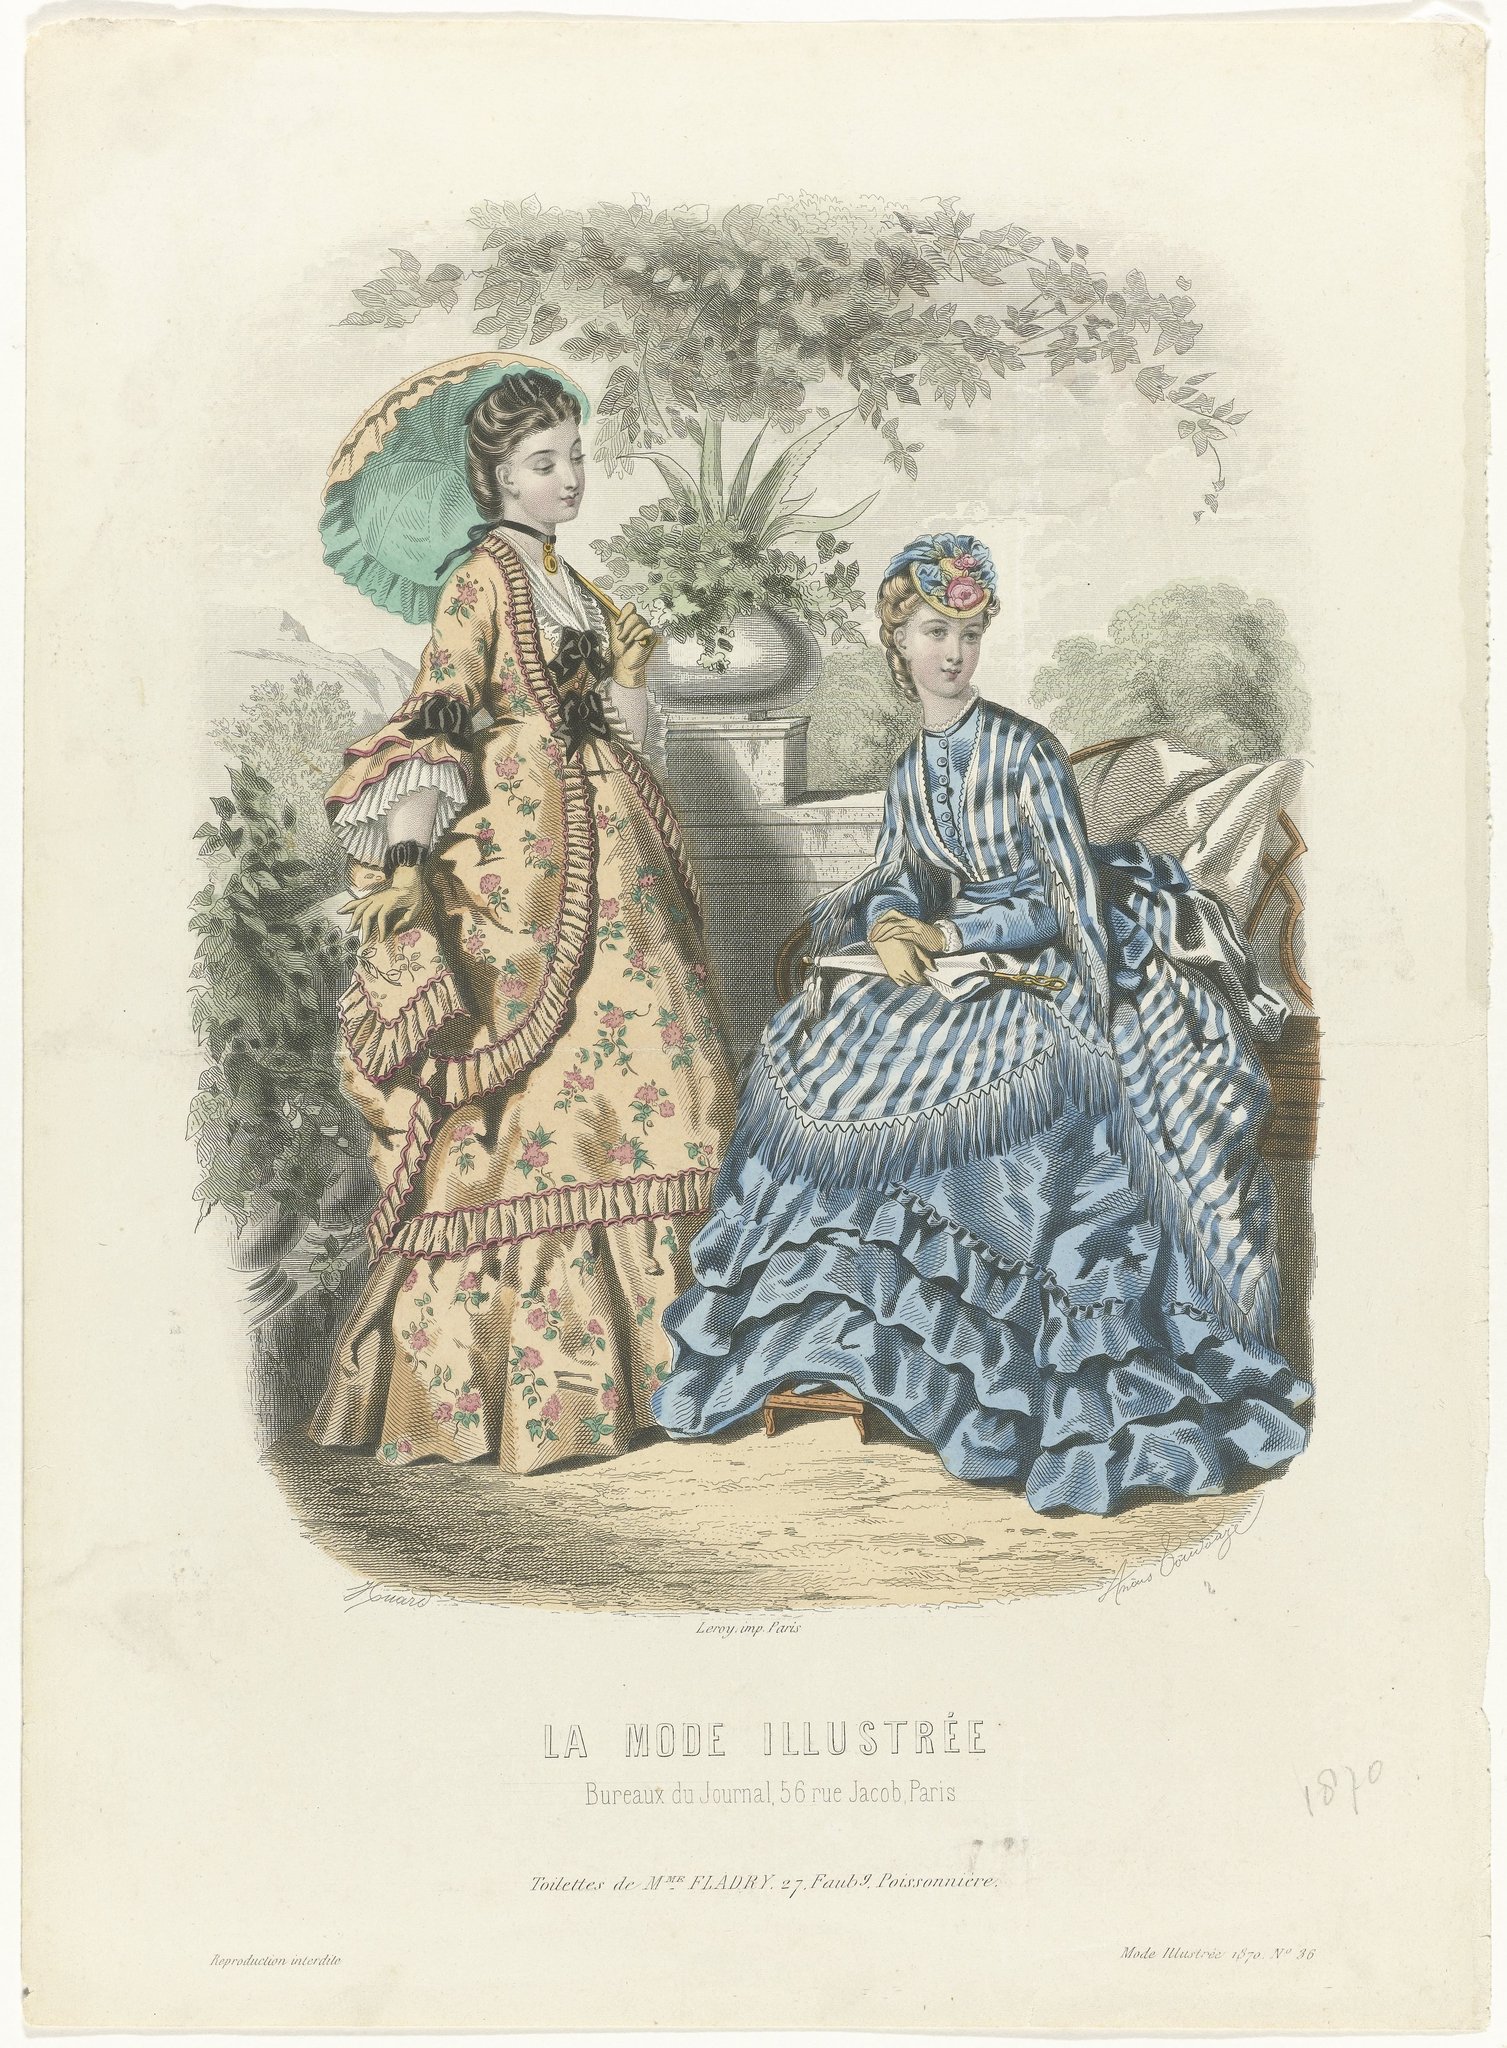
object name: fashion print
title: La Mode Illustrée, 1870, No. 36: Toilettes de Mme Fladry (...)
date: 1870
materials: paper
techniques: hand coloring, engraving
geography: paris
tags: bow (ornamental part of clothing) (+ women's clothes), pendant, trinket, 'breloque' (+ women's clothes), footstool, head-gear (+ women's clothes), fashion plates, skirt (+ women's clothes), gloves, mittens, etc. (+ women's clothes), dress, gown (+ women's clothes), neck-gear ~ clothing (+ women's clothes), sleeves (+ women's clothes), parasol, sunshade (+ women's clothes)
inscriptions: caption: ‘Toilettes de Mme Fladry. 27. Faubg Poissonnière.’, title: ‘La Mode Illustrée’, address: ‘Bureaux du Journal, 56, Rue Jacob. Paris’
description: Twee vrouwen zijn buiten, gekleed in japonnen van Fladry. Prent uit het modetijdschrift La Mode Illustrée (1860-1937).